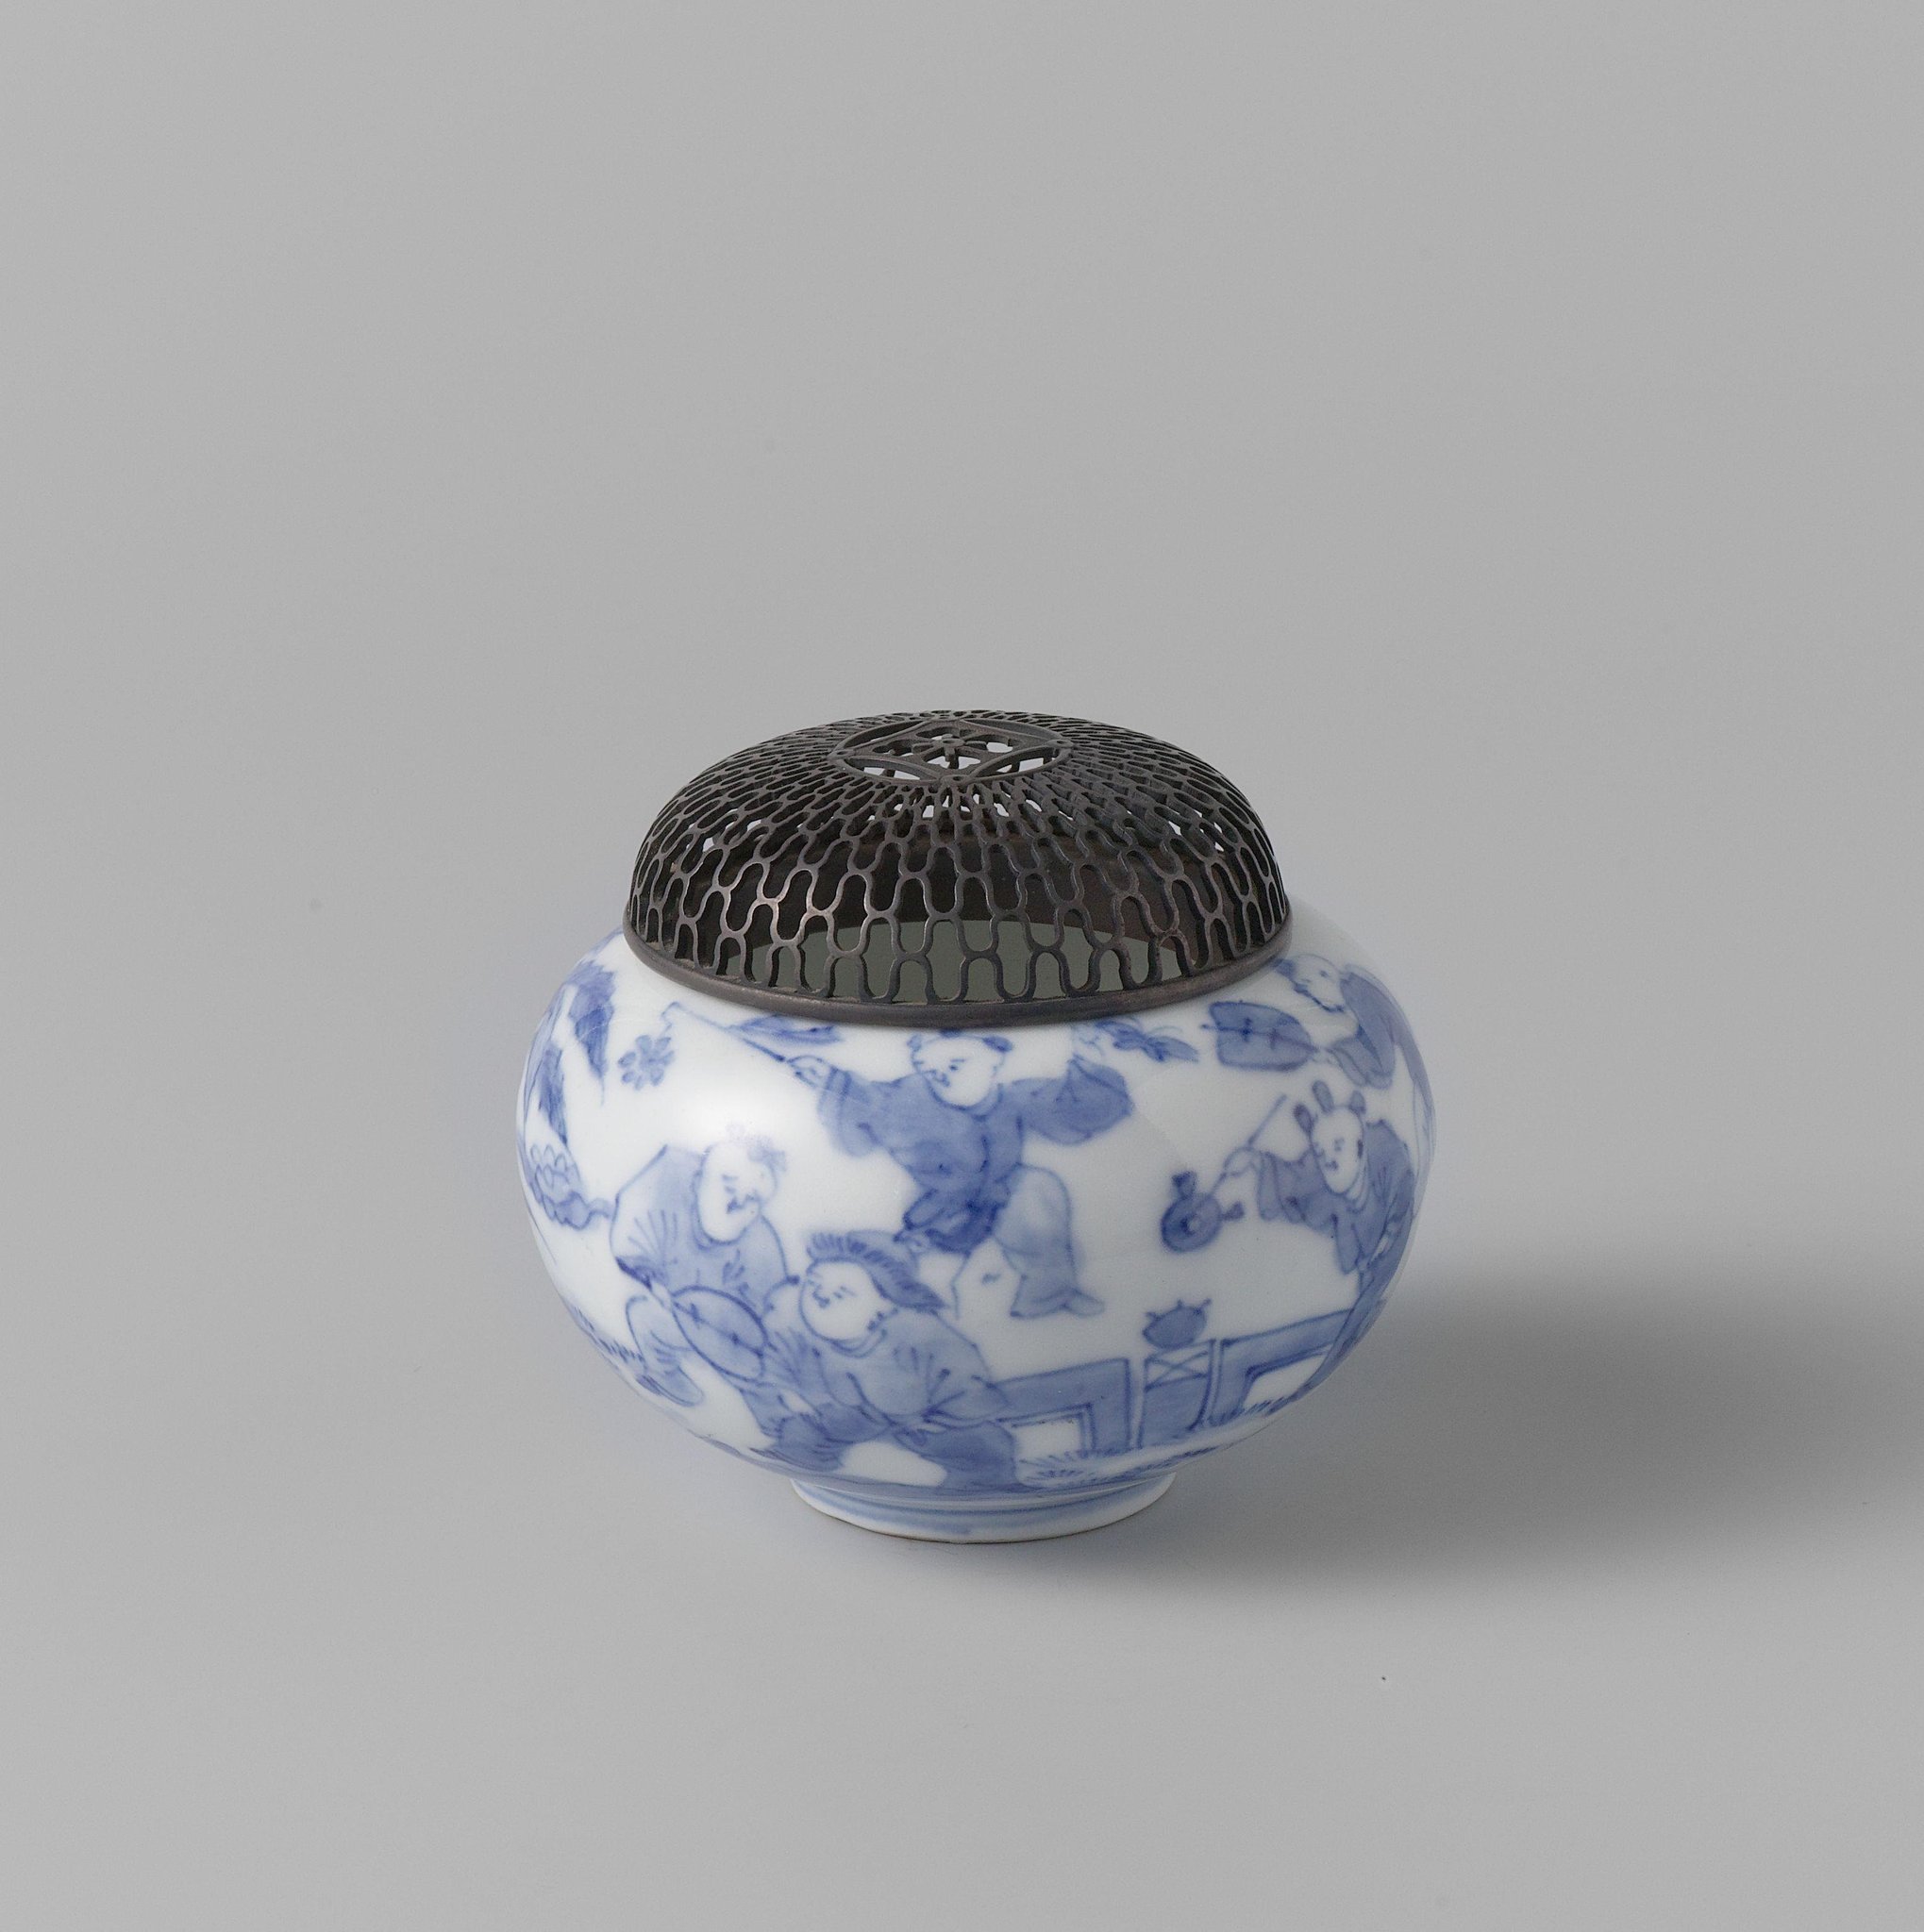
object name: incense burner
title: Incense burner with playing boys in a fenced garden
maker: Anonymous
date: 1800-1899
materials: cobalt, glaze, metal, paint, porcelain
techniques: embroidery, firing, turning, vitrification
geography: japan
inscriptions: label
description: Wierookbrander (koro) van porselein met een gedrukt, bolvormig lichaam, beschilderd in onderglazuur blauw. Op de wand een groep van zeven jongens in een omheinde tuin spelend met waaiers, vliegers, etc. Het tafereel wordt afgesloten door een bananenplant bij een rots. Op de onderzijde een oud label. Hirado.